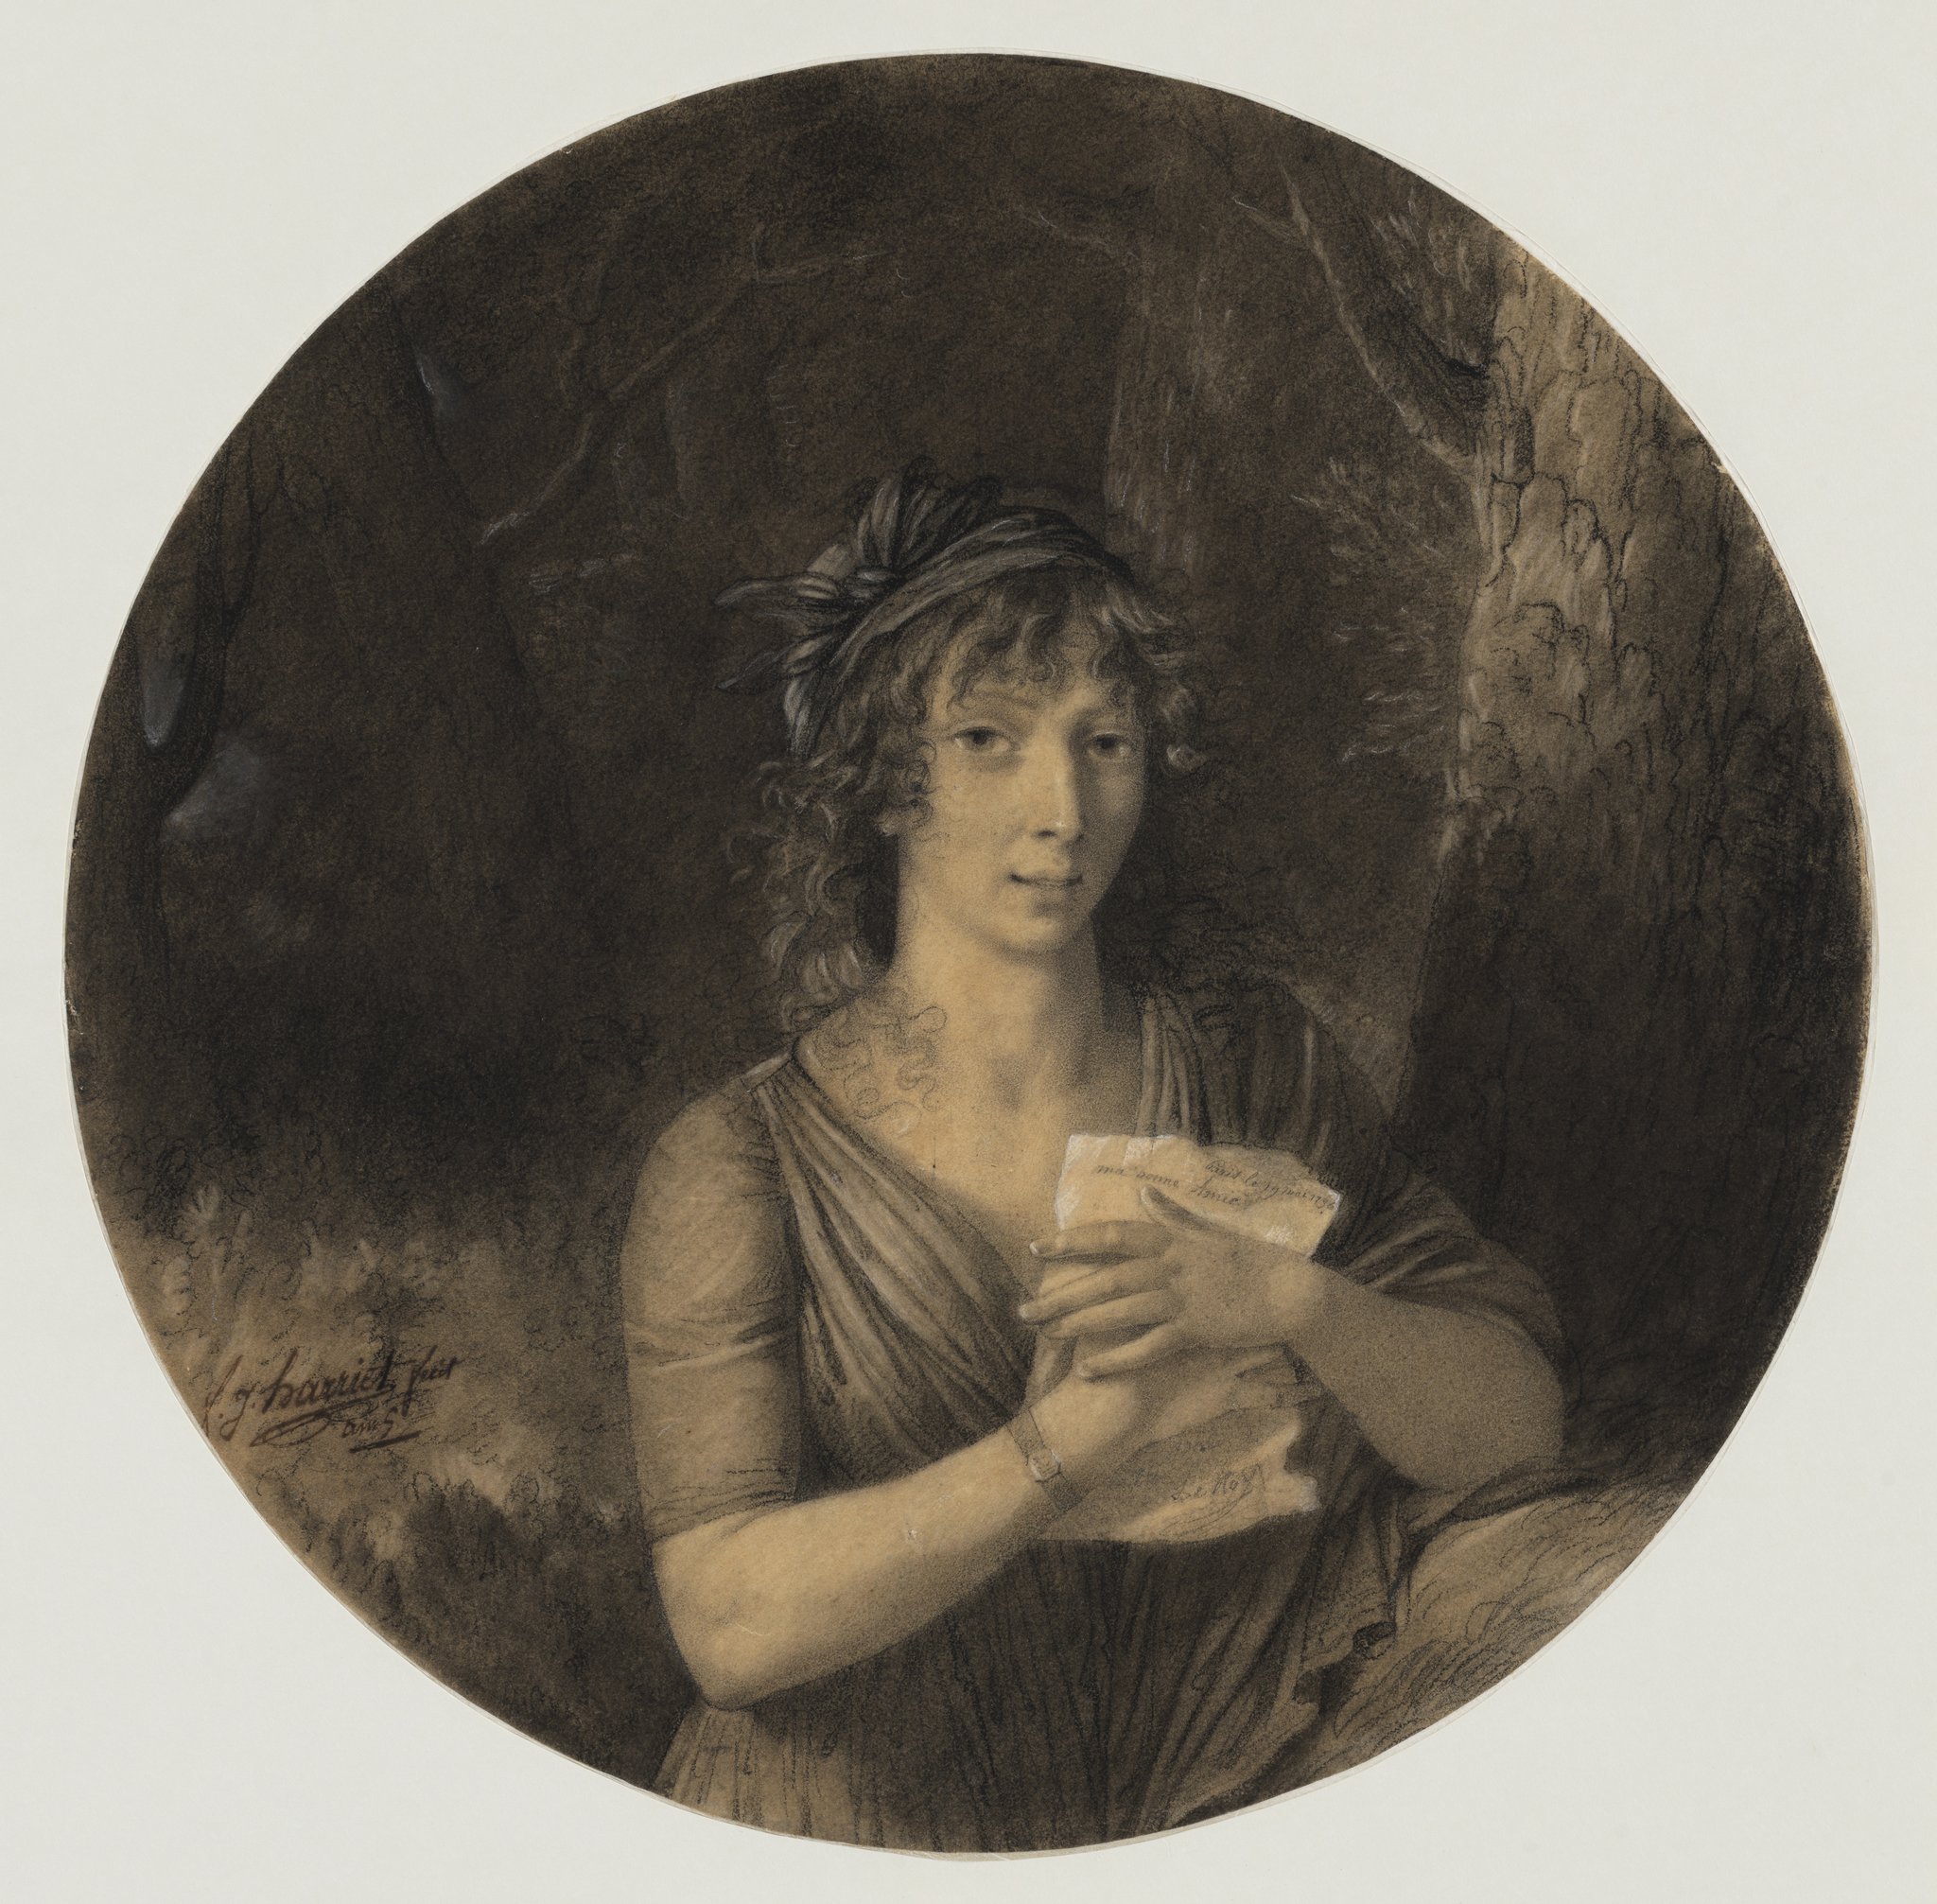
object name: drawing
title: Portrait of a woman, possibly Sébastienne Gallet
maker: fulchran jean harriet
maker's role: artist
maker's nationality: french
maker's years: 1776-1805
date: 1796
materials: chalk, graphite